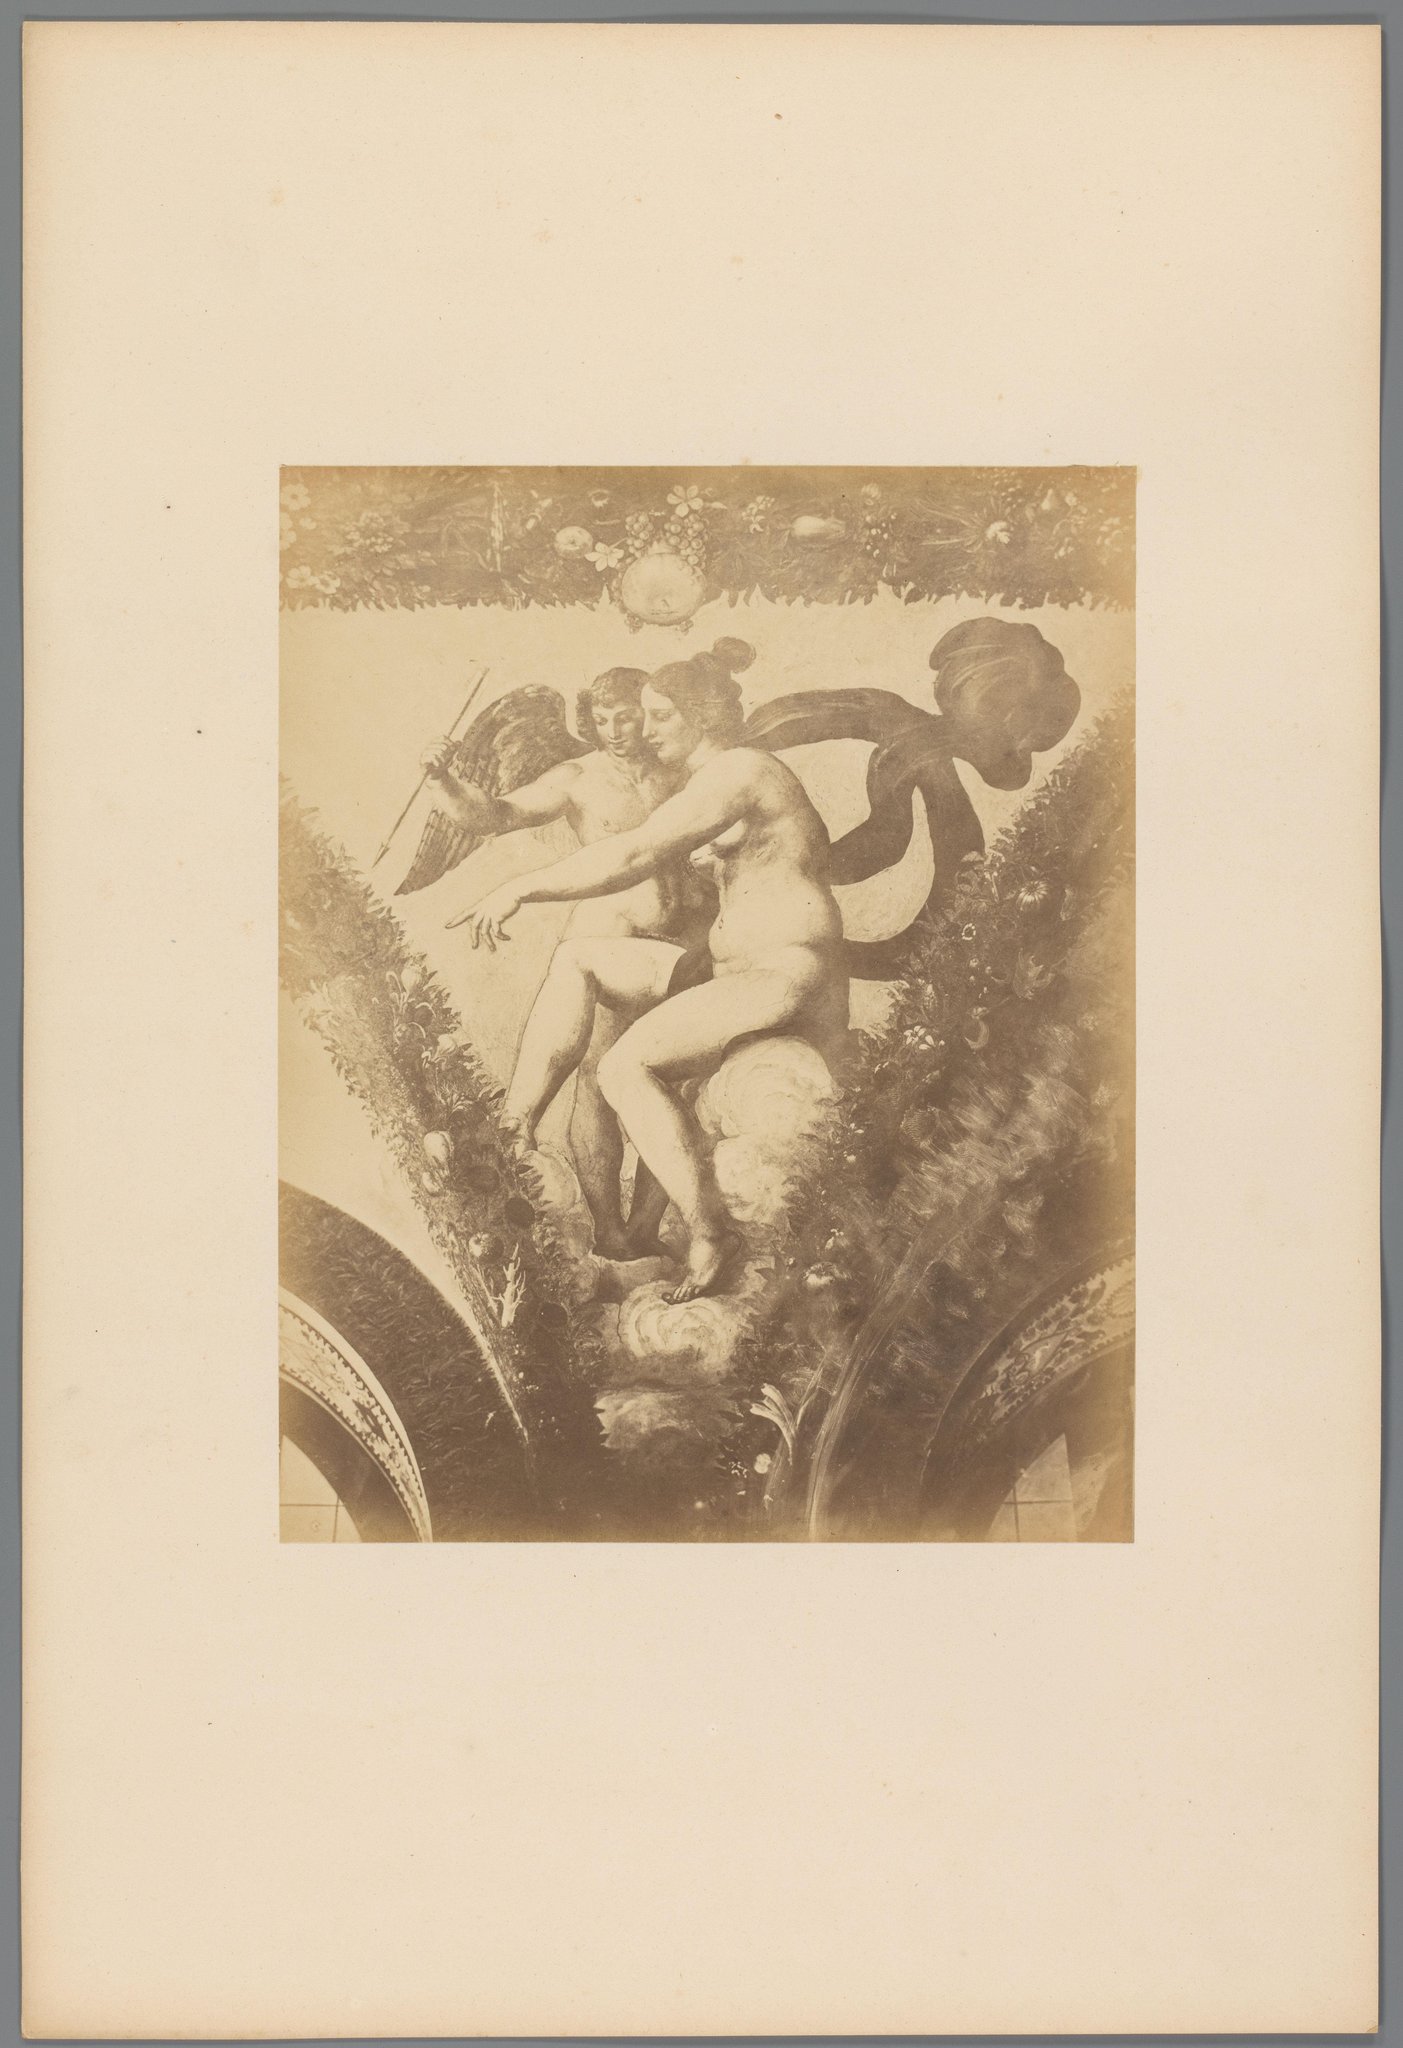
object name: reproduction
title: Fotoreproductie van het fresco Venus en Cupido naar Rafaël in de Villa Farnesina te Rome, Italië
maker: Anonymous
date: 1851-1900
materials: cardboard, paper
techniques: albumen print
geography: rome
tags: wall-covering, venus and cupid (cupid not being mere attribute)